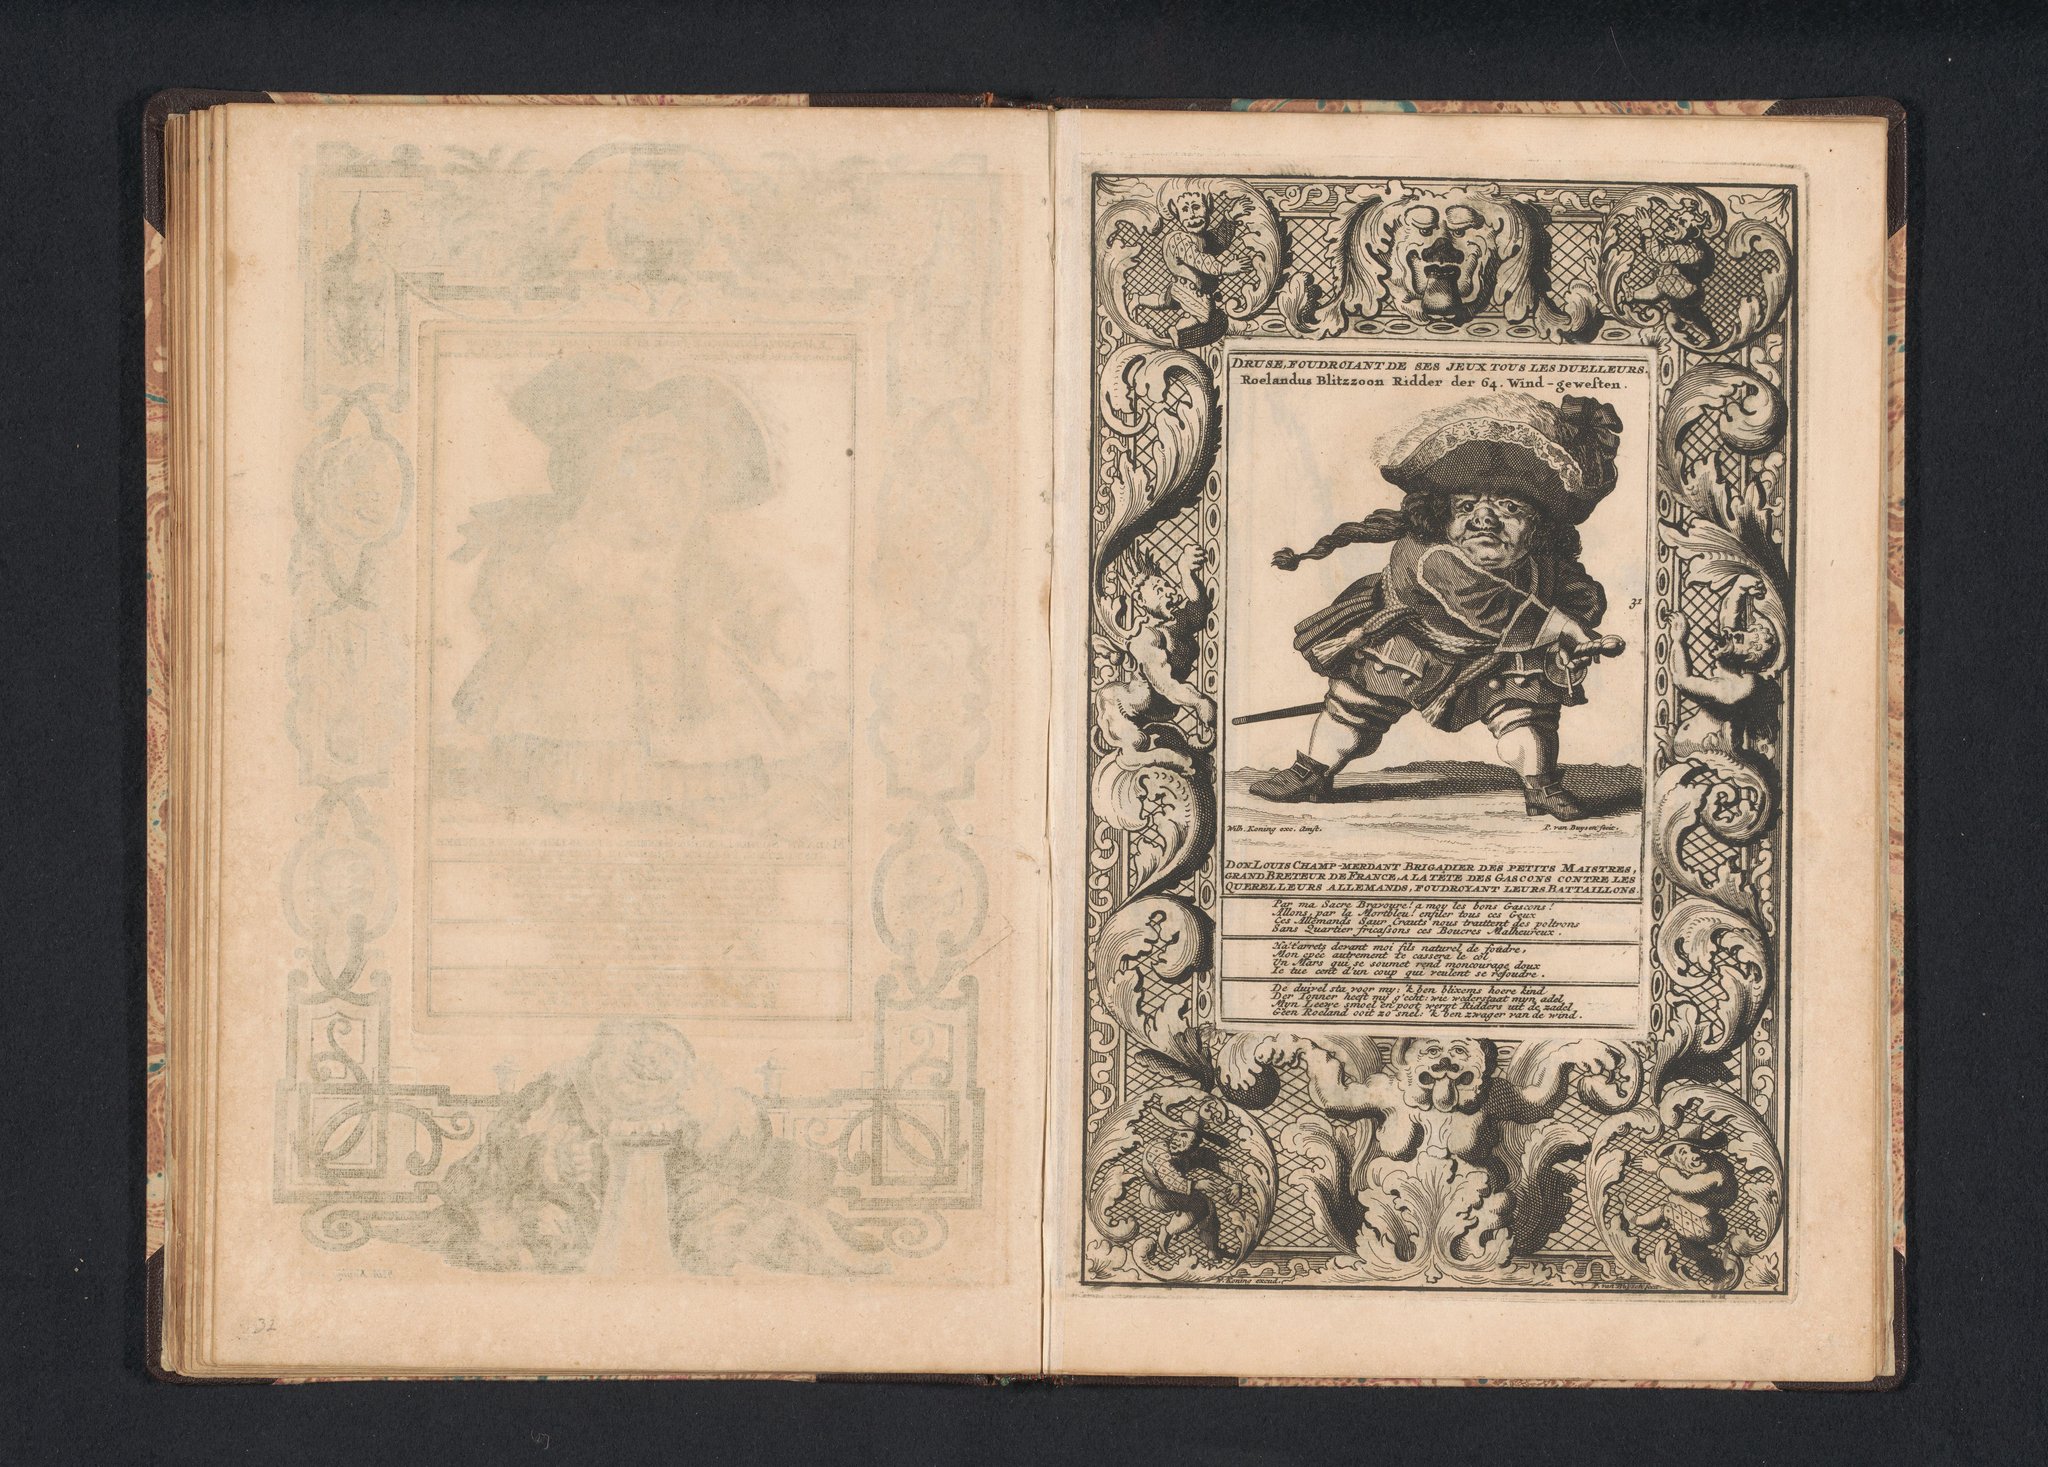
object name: print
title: De kleine mens Roelandus Blitzzoon, 1716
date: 1716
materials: paper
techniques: etching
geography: northern netherlands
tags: caricatures (human types), little people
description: De kleine mens Roelandus Blitzzoon. In het onderschrift verzen in het Duits, Frans en Nederlands. Afdruk binnen een decoratieve omlijsting gedrukt van een aparte plaat met duivels en harlekijnen. Genummerd rechts midden: 31. Onderdeel van de Nederlandse gebonden uitgave uit 1716 van een serie karikaturen van kleine mensen, bekend als Het Dwergentooneel, gekopieerd naar een ouder Duits voorbeeld.